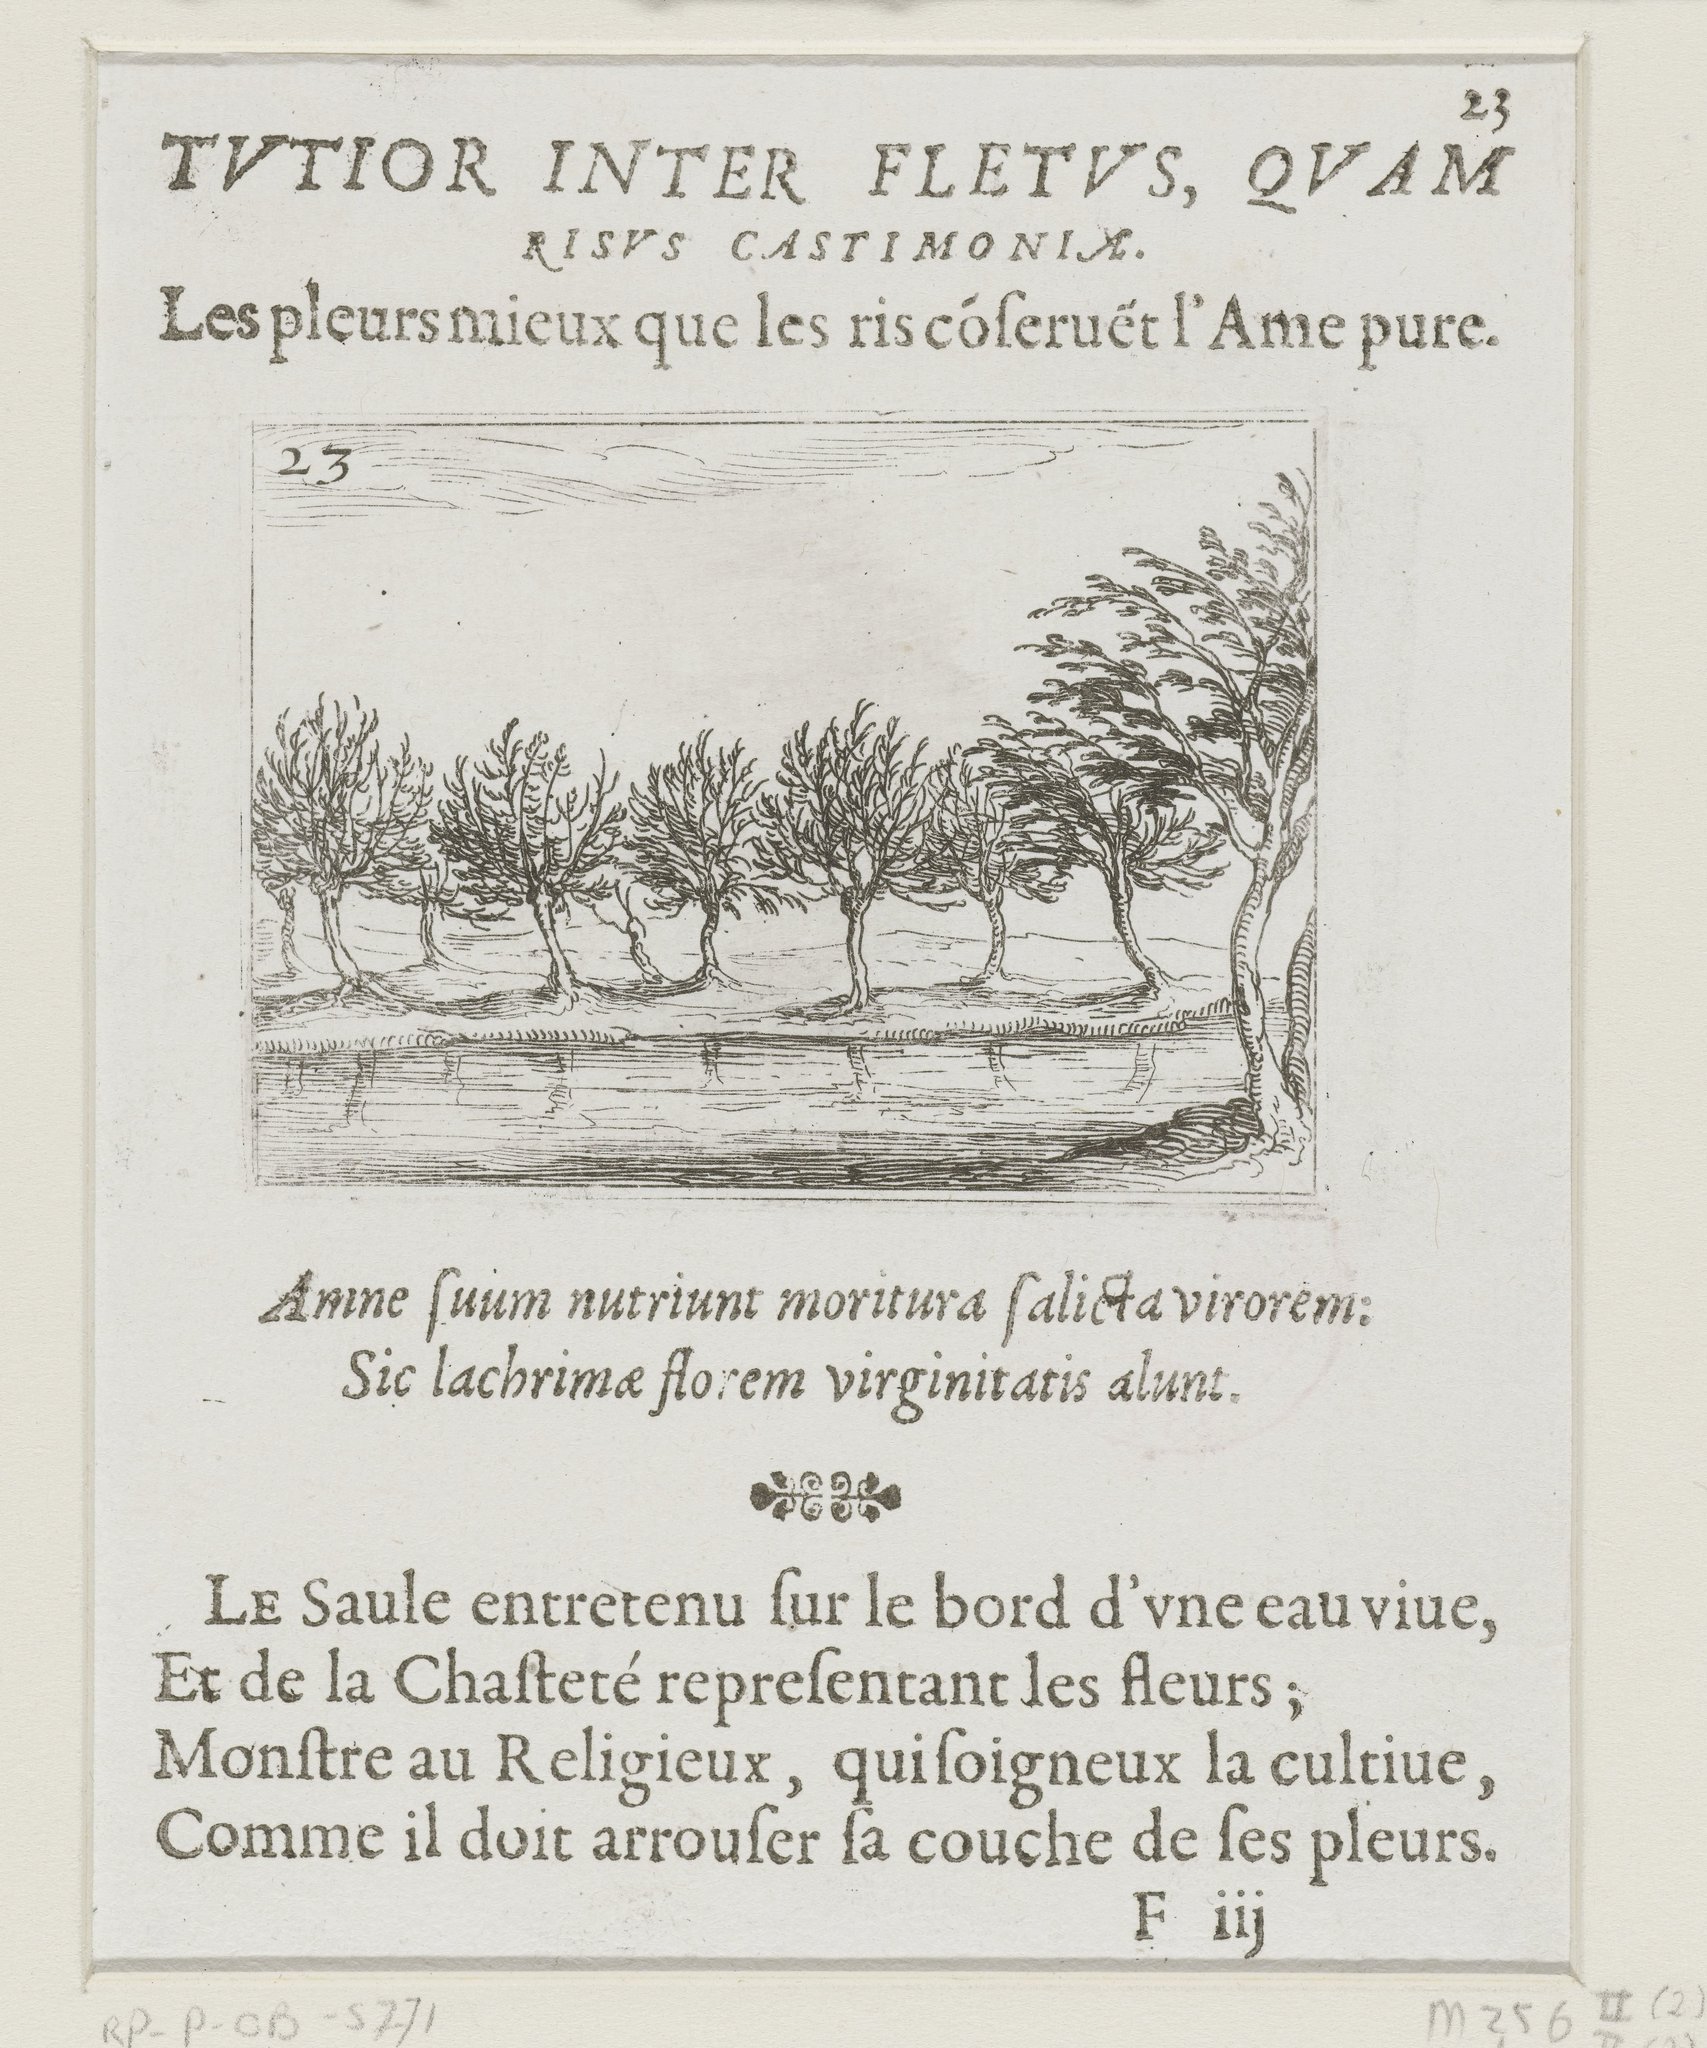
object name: cognizance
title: Wilgen langs een oever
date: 1621-1635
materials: paper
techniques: etching, letterpress printing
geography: paris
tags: trees: willow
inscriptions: collector's mark: Lugt 240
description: Voorstelling van een rij wilgen langs een oever. Boven en onder deze prent Latijnse en Franse teksten in boekdruk. Dit blad is onderdeel van de embleemserie 'Kloosterleven in emblemen'. De tweede staat van deze serie behelst naast een geïllustreerde titelpagina en 26 emblemen nog een titelpagina en een blad met opdracht, beide in boekdruk zonder afbeelding.